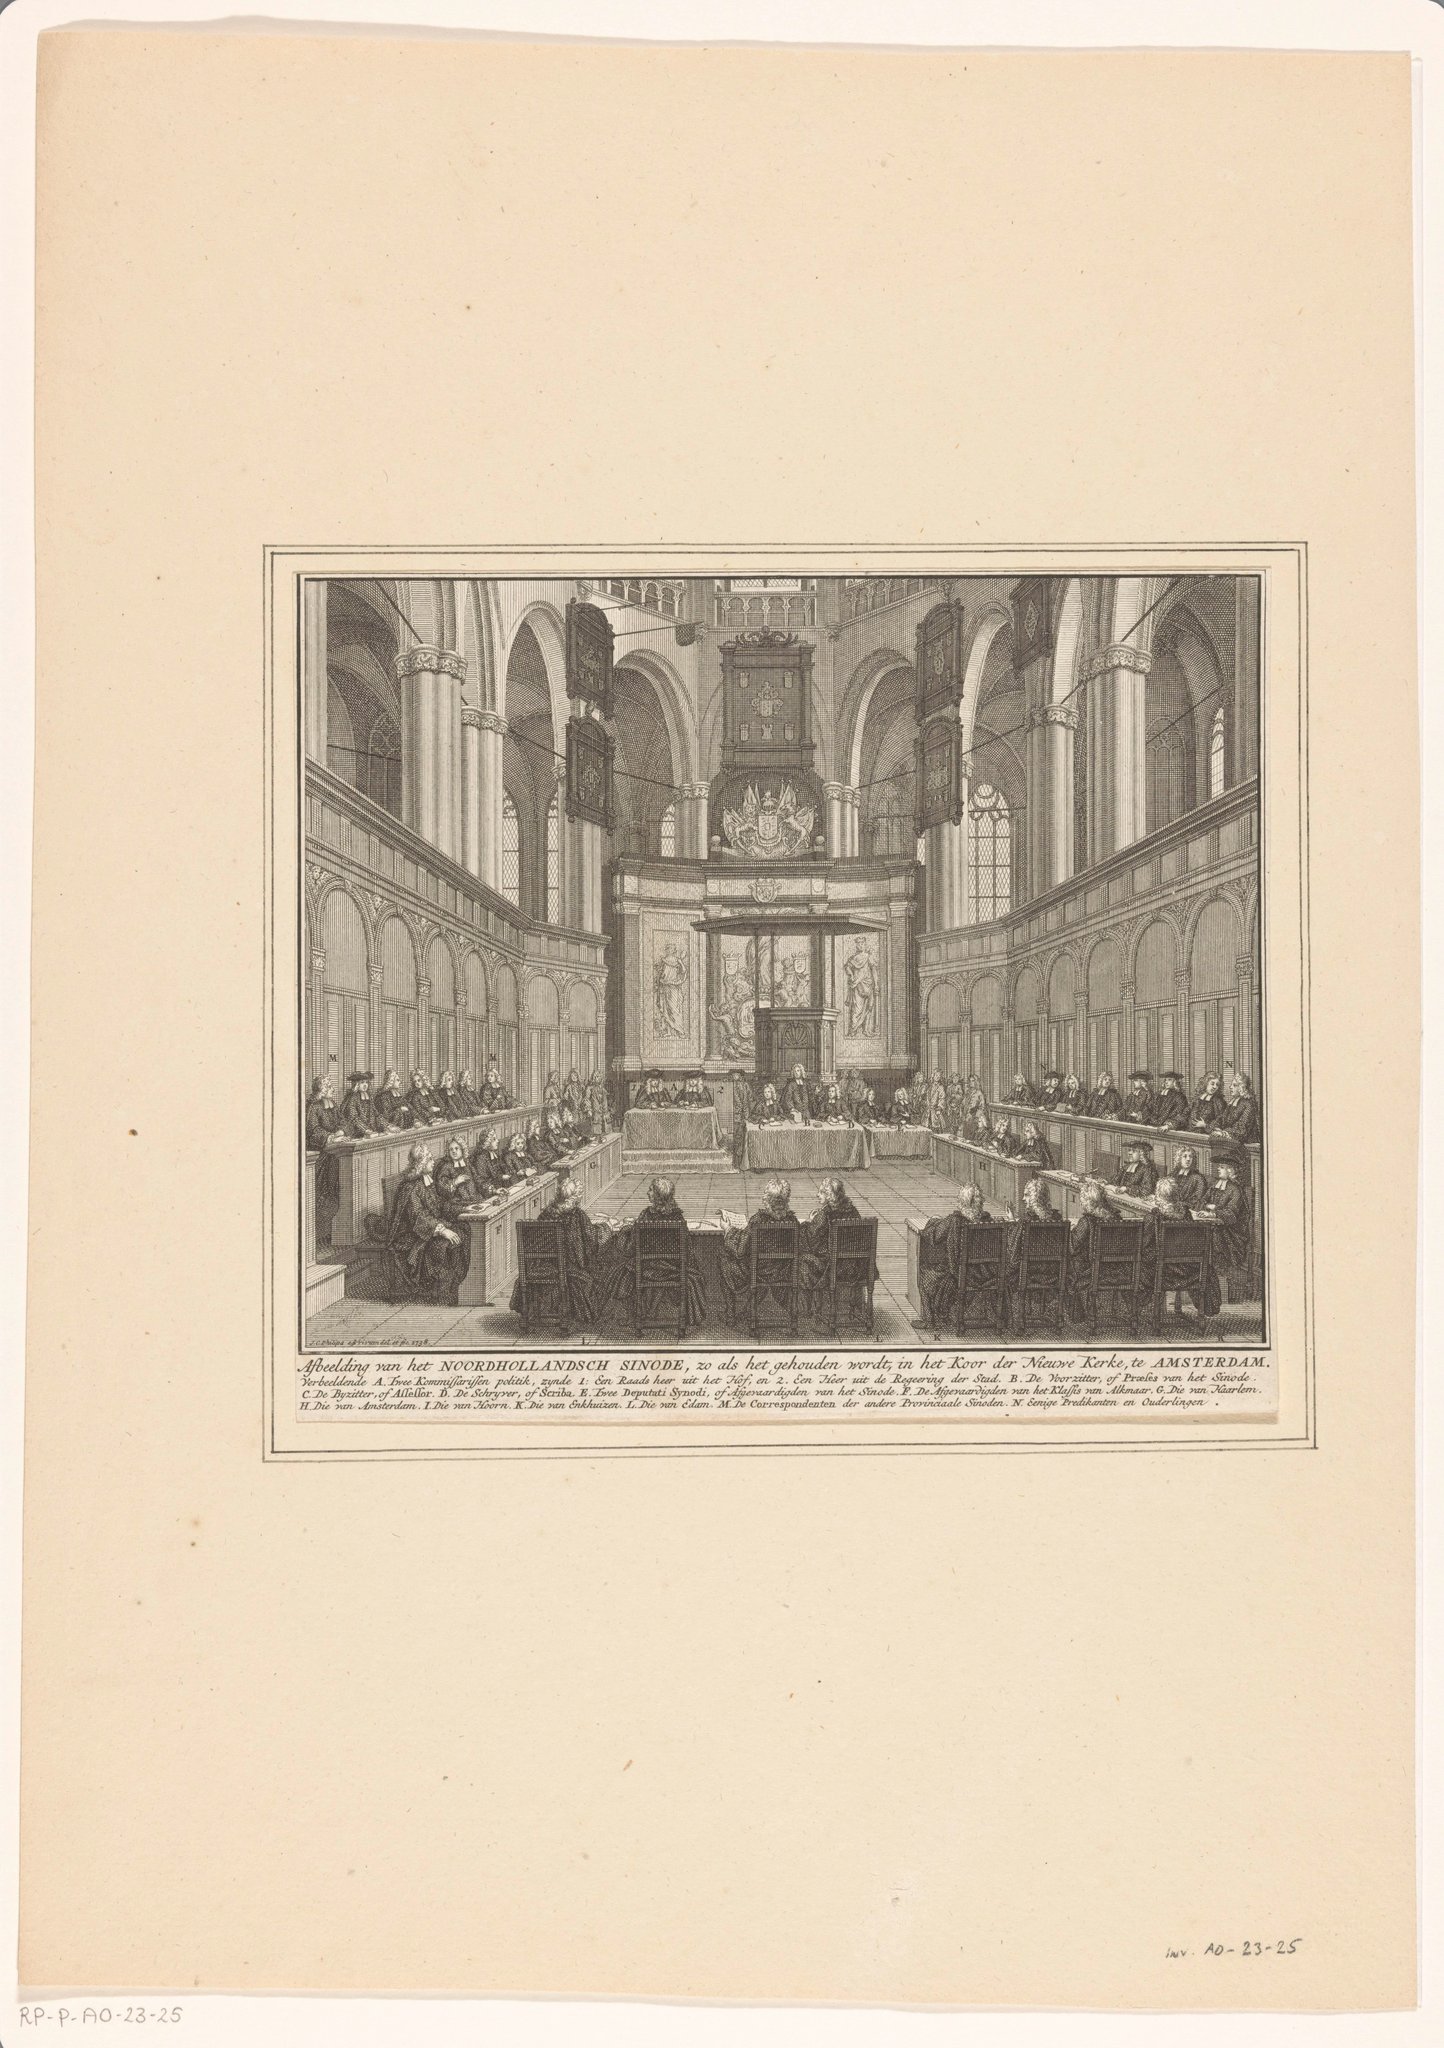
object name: print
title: Synode gehouden in de Nieuwe Kerk te Amsterdam, 1730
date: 1738-1739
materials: paper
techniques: engraving, etching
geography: amsterdam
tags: organizations, assemblies, etc. in protestant churches, interior of church, parts of church interior: choir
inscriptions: collector's mark: Lugt 195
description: Prent ook gebruikt in: Wagenaar, Jan. Tegenwoordige staat der Vereenigde Nederlanden, eerste deel. Vervattende eene algemeene beschryving des lands (…) / Hedendaagsche historie, of tegenwoordige staat der Vereenigde Nederlanden. XIde deel (…). Amsterdam: Isaak Tirion, 1739, p. 34.